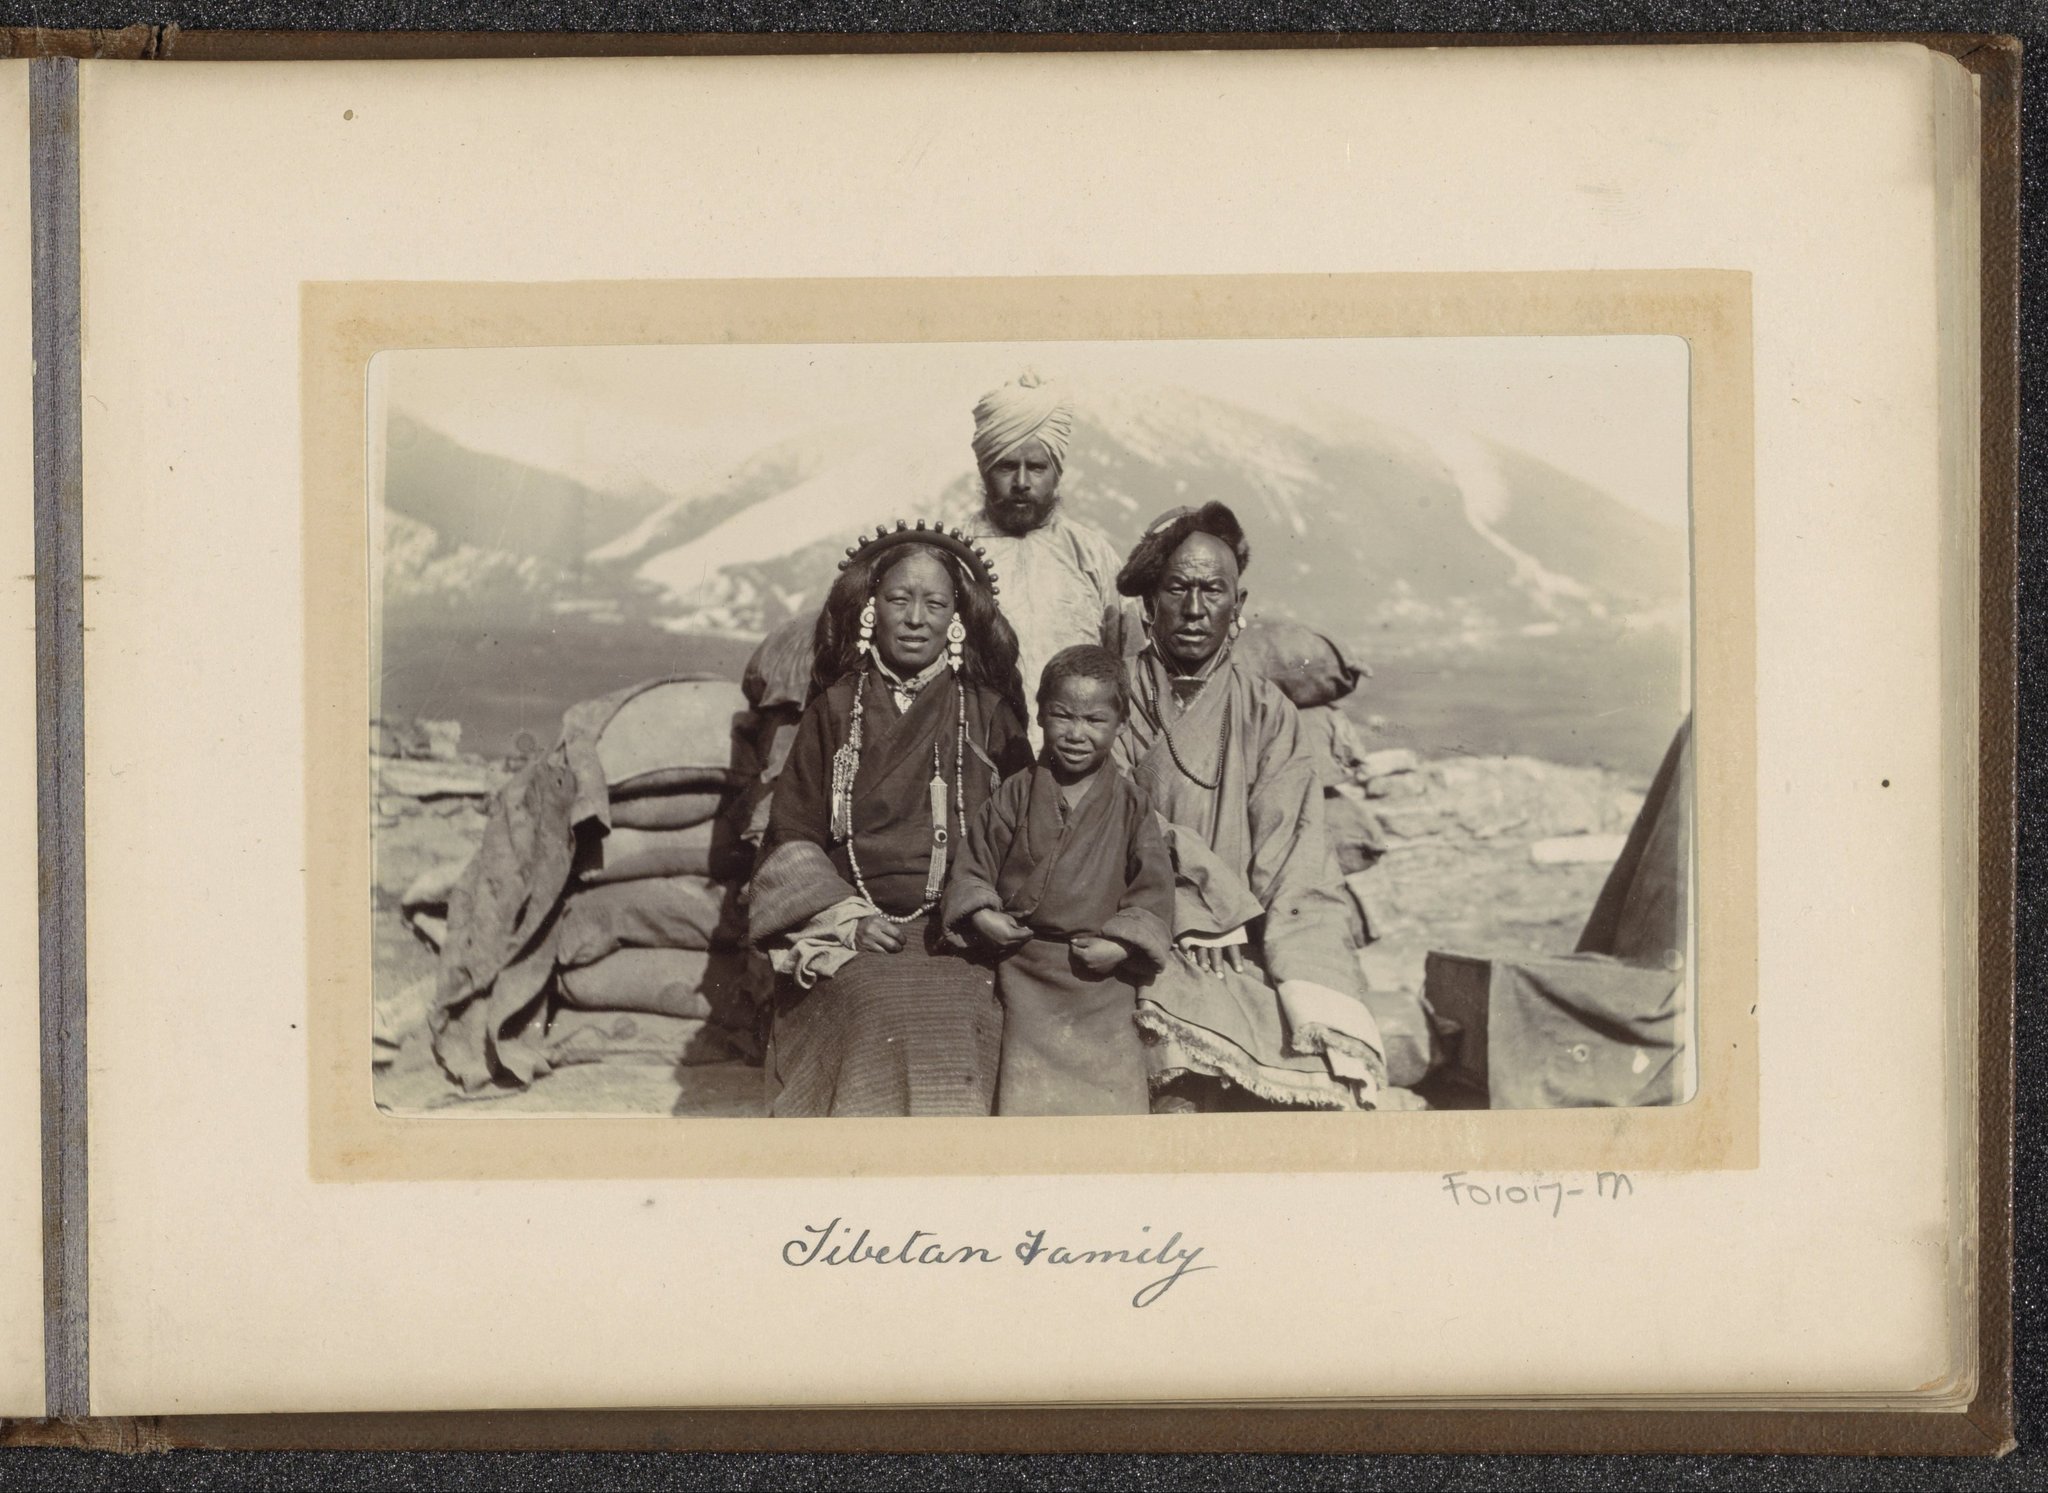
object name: photograph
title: Army intendent with three members of a Tibetan family, Tibet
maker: d.t. dalton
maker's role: sergeant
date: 1903-1906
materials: photographic support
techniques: gelatin silver print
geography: tibet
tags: clothing for the lower part of the body, head-gear, clothing for the upper part of the body, family, relationship, descent, clothes covering the entire body, mountains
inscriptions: title: ‘Tibetan Family’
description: Onderdeel van Fotoalbum met 24 foto's van de reis van legertelegrafist D.T. Dalton door Tibet.